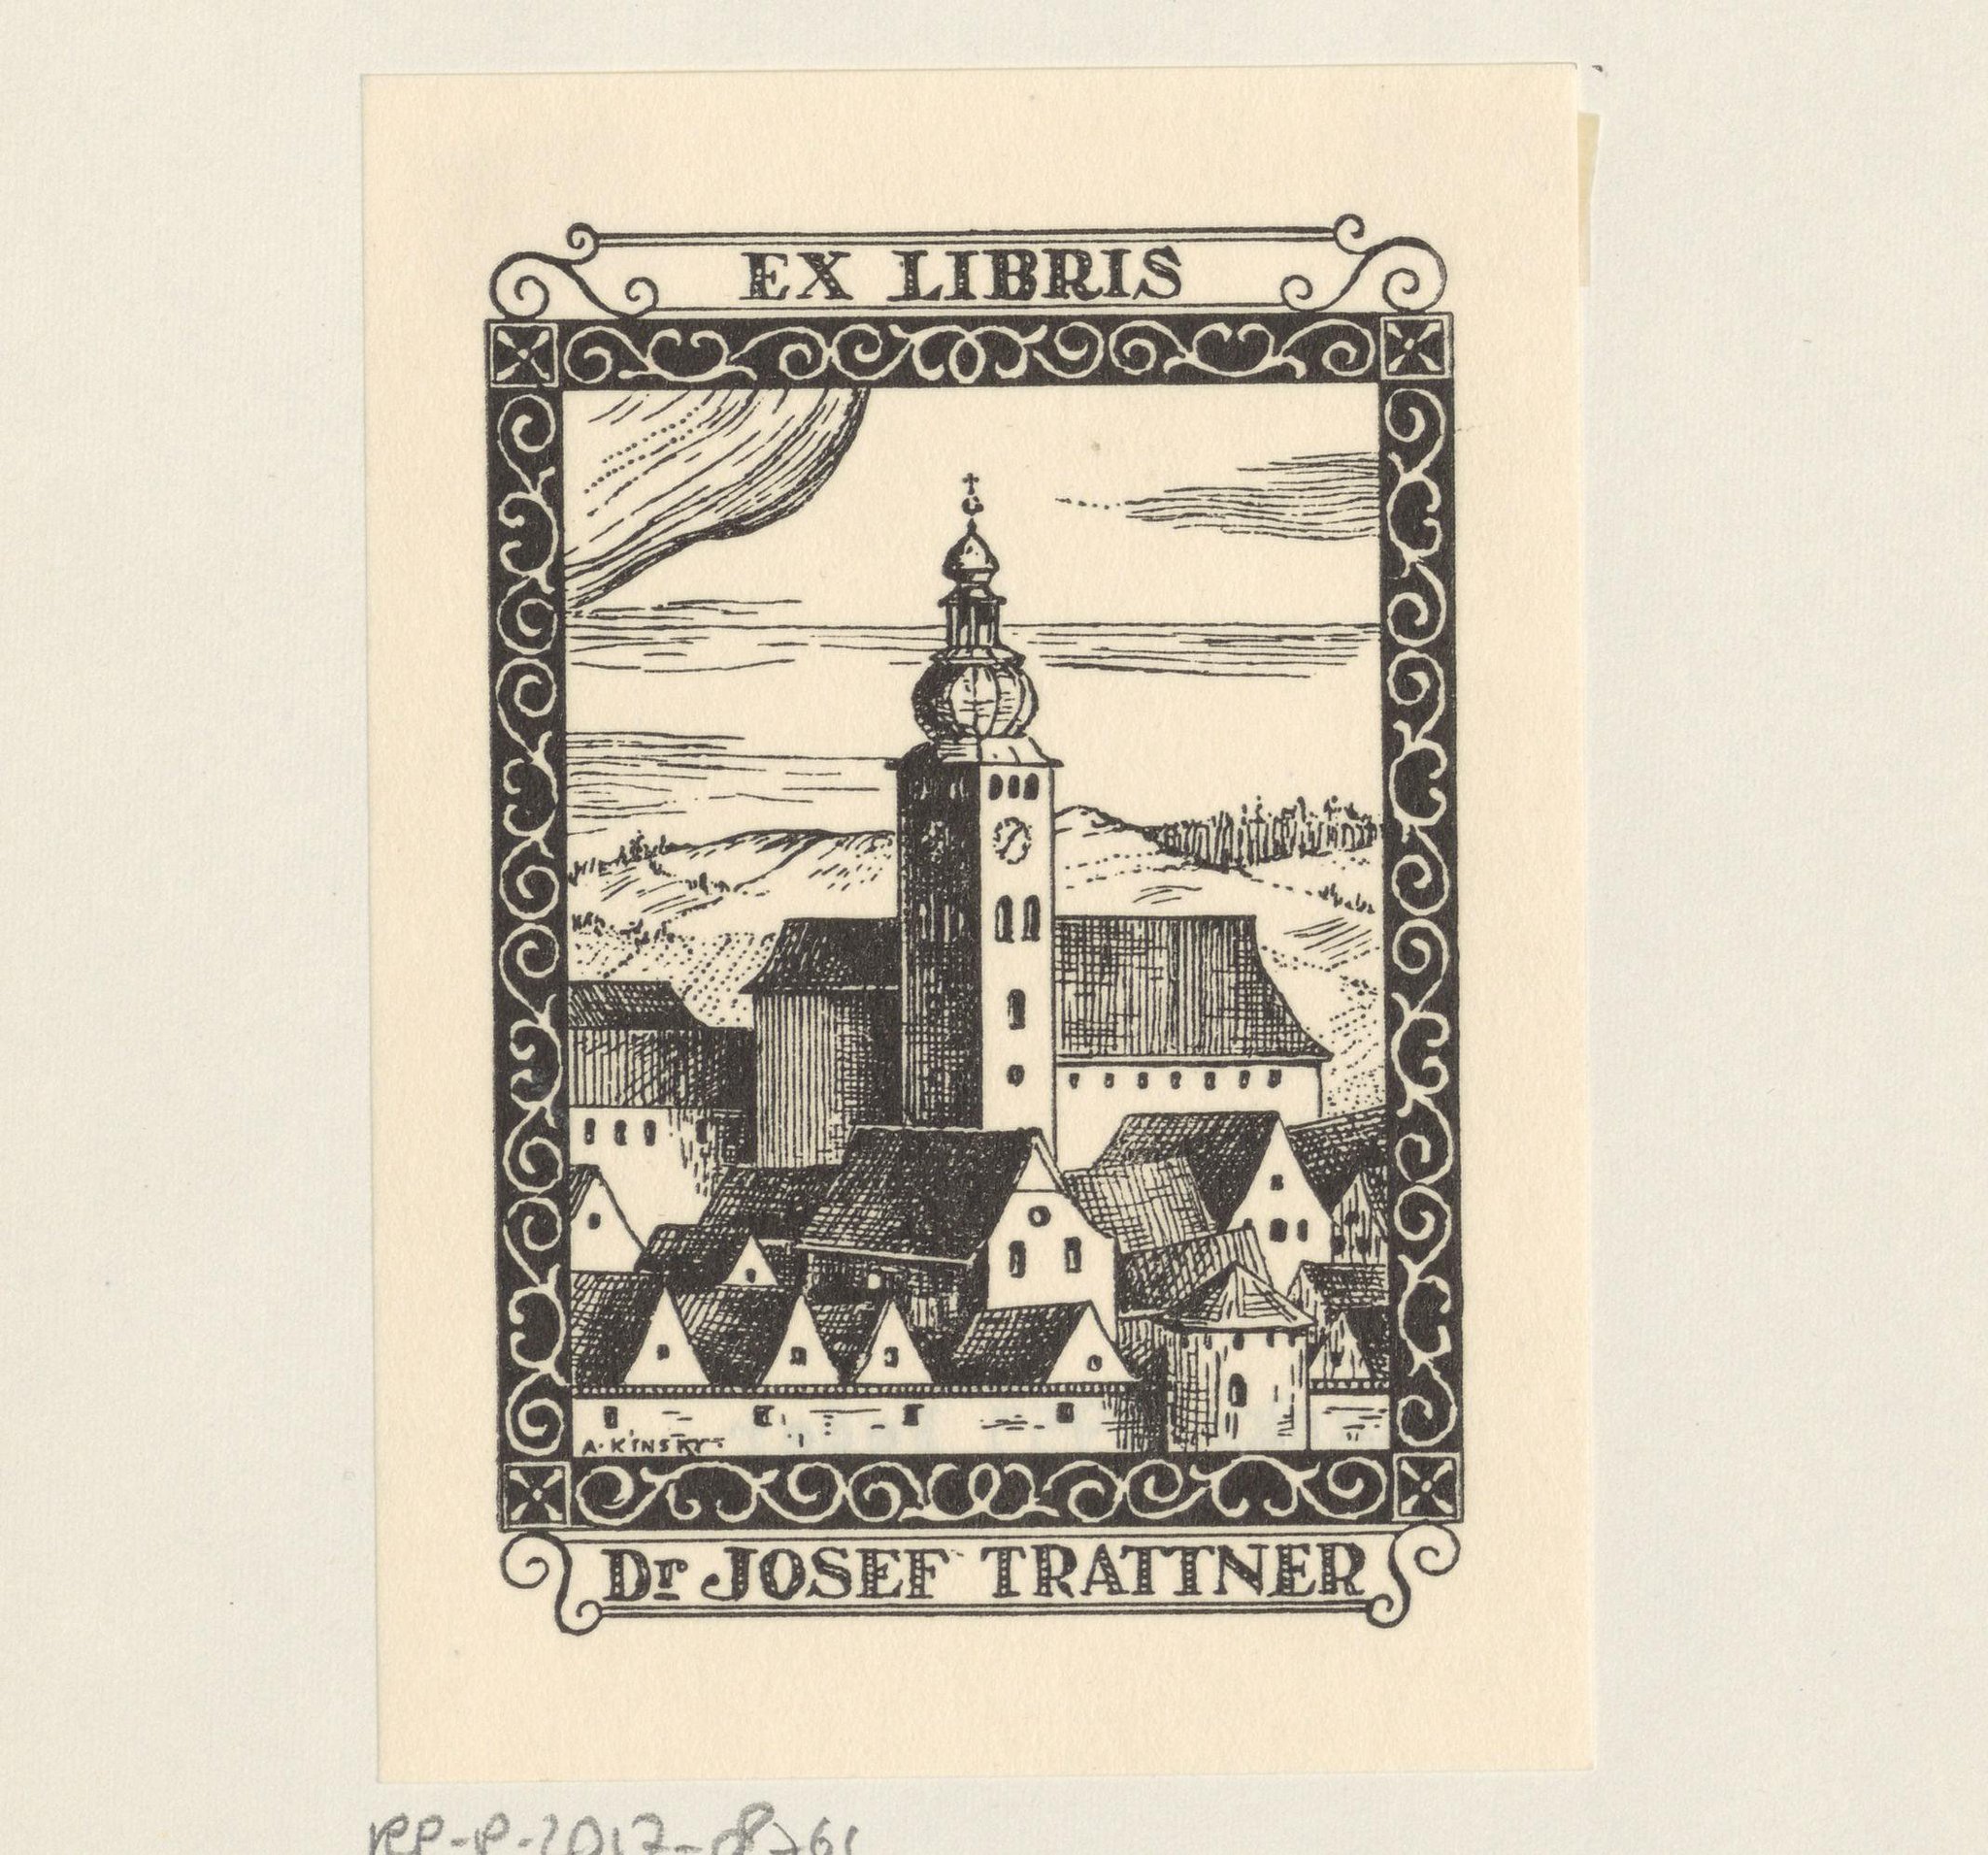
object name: bookplate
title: Ex libris van Josef Trattner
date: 1953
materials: paper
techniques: printing block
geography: austria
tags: church (exterior), prospect of city, town panorama, silhouette of city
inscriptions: inscription: ‘Kinsky 1955 Feder’